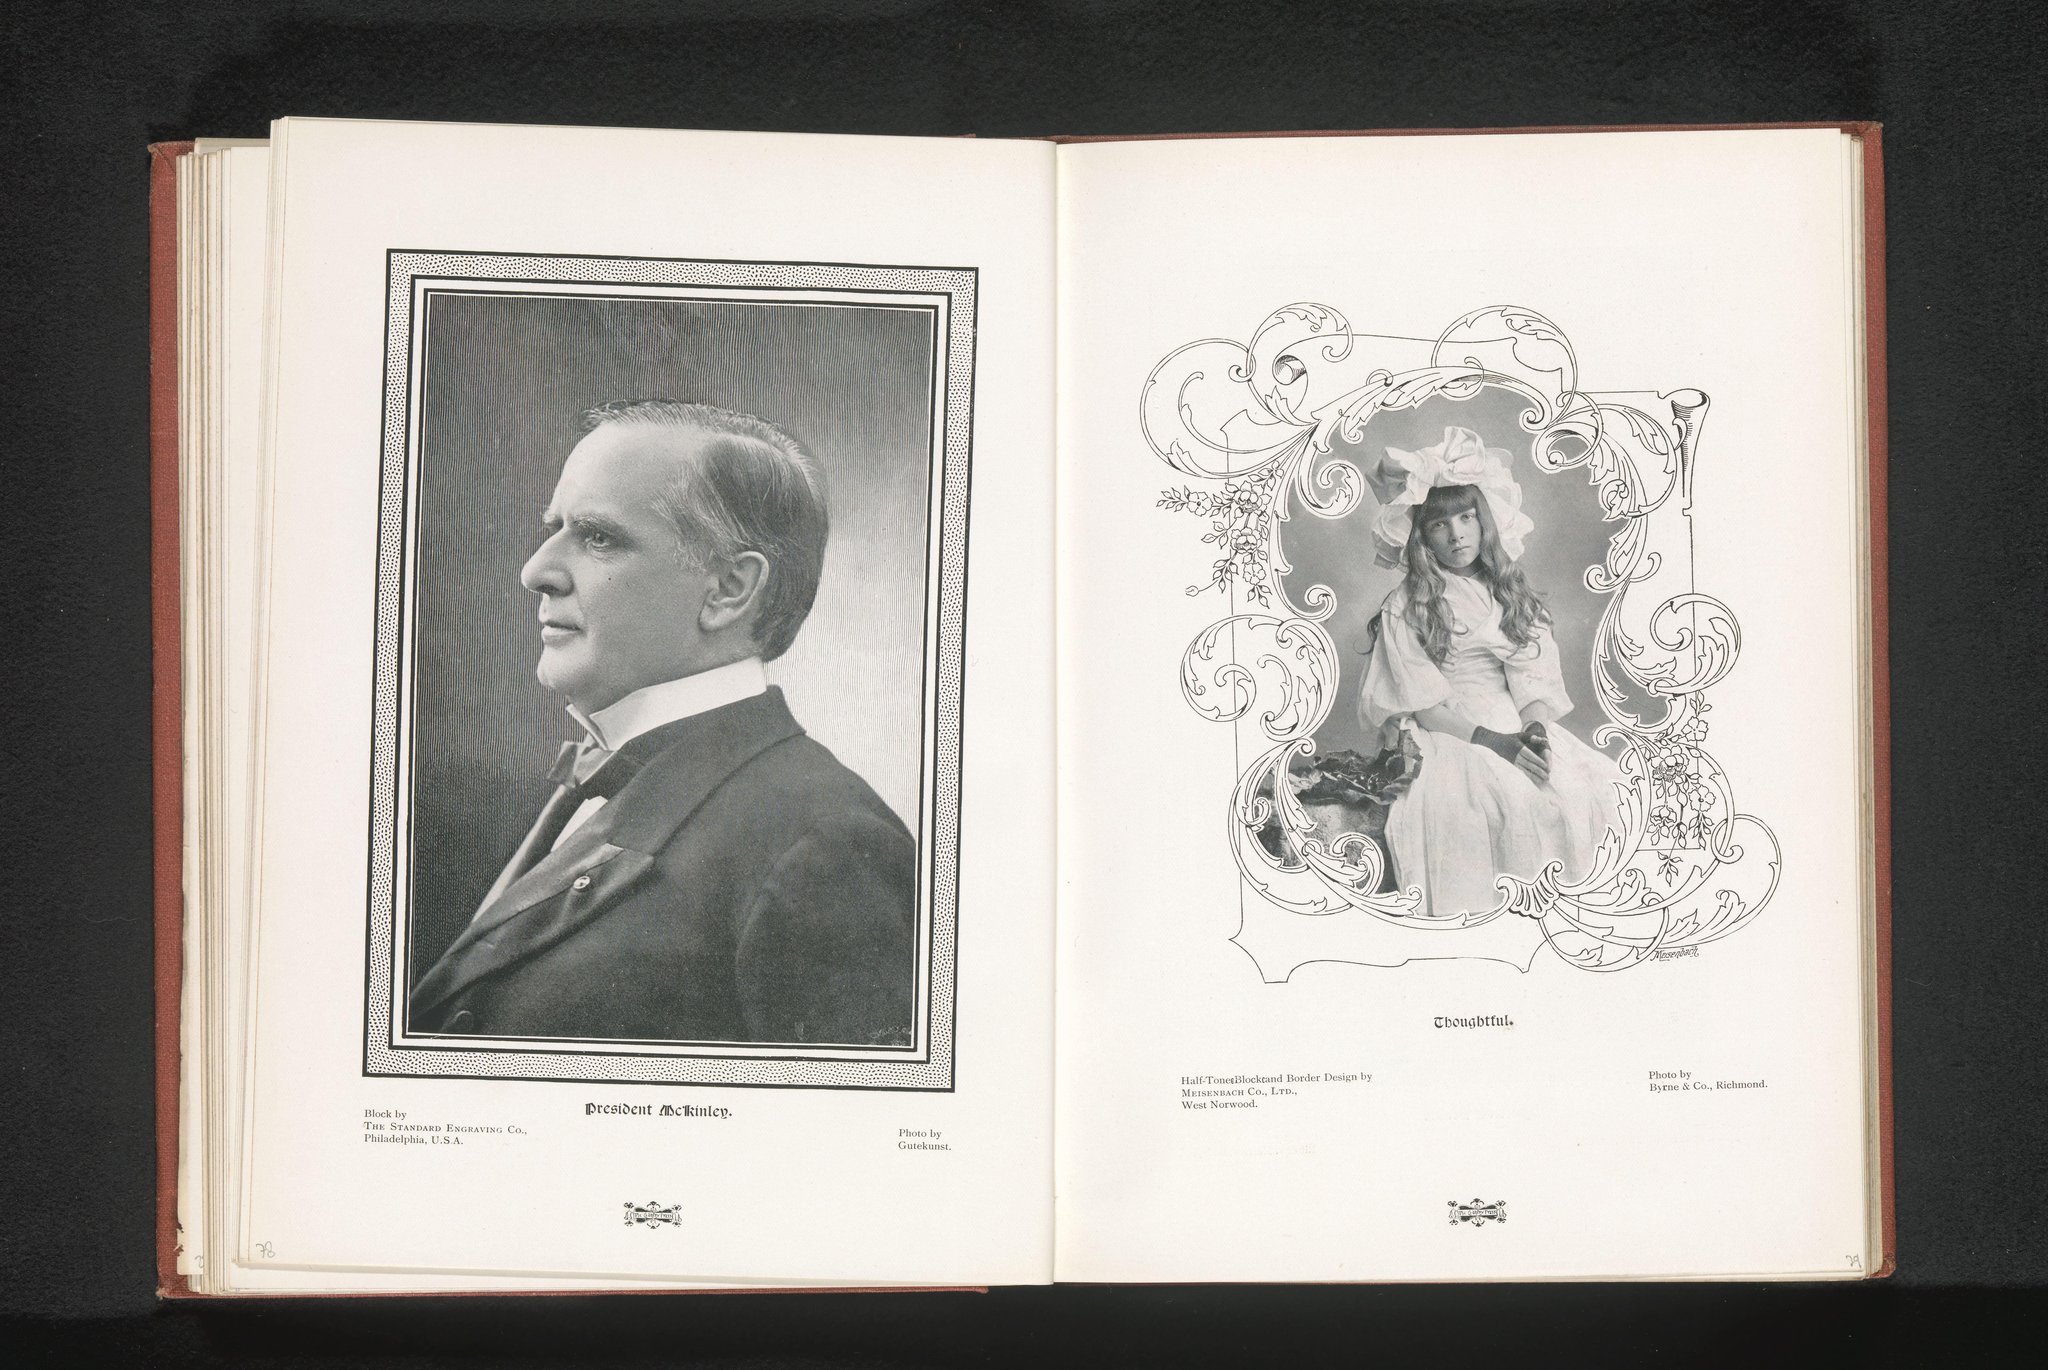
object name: page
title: Portret van een onbekend meisje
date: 1895-1900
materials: paper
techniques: autotype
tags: historical persons - bb - woman, girl (child between toddler and youth)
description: Prent op derde ongenummerde pagina na pagina 64.